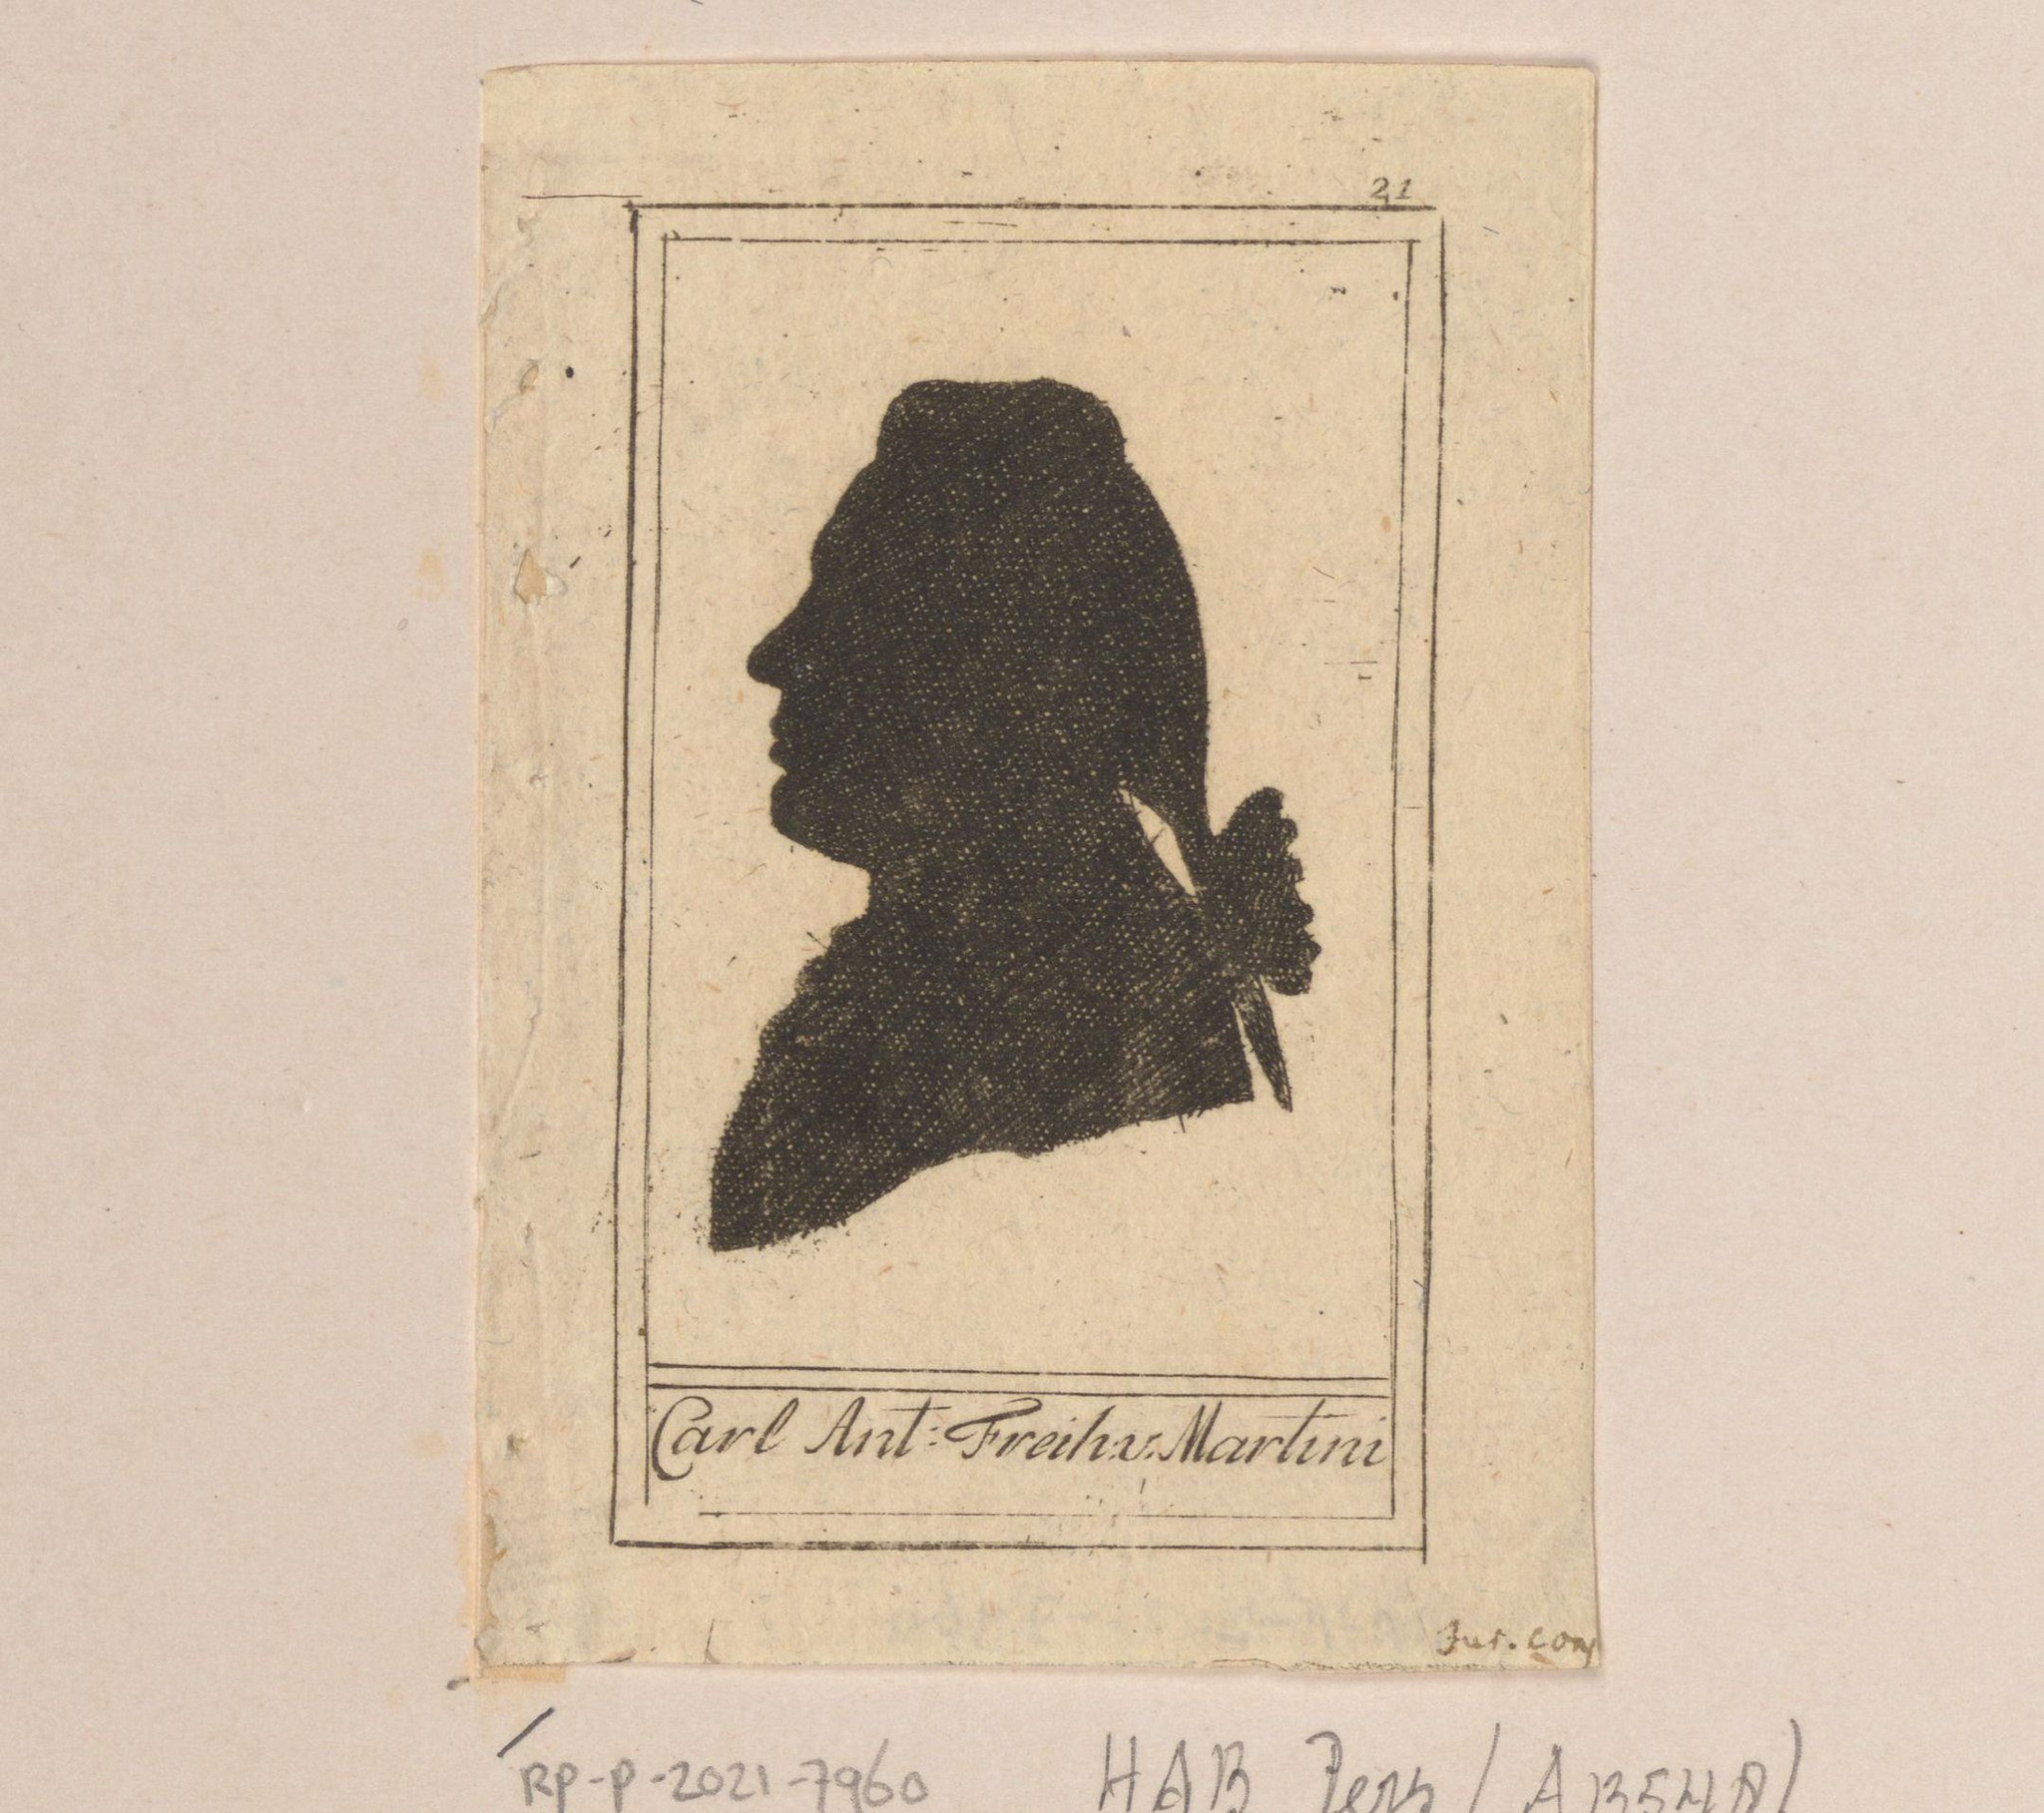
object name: book illustration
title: Silhouetportret van Karl Anton von Martini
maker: hieronymus löschenkohl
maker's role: print maker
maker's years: 1753-1807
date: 1763-1807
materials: paper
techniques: etching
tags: vienna, historical persons, lawyer, attorney at law, wig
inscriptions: inscription: ‘Jur. cons.’